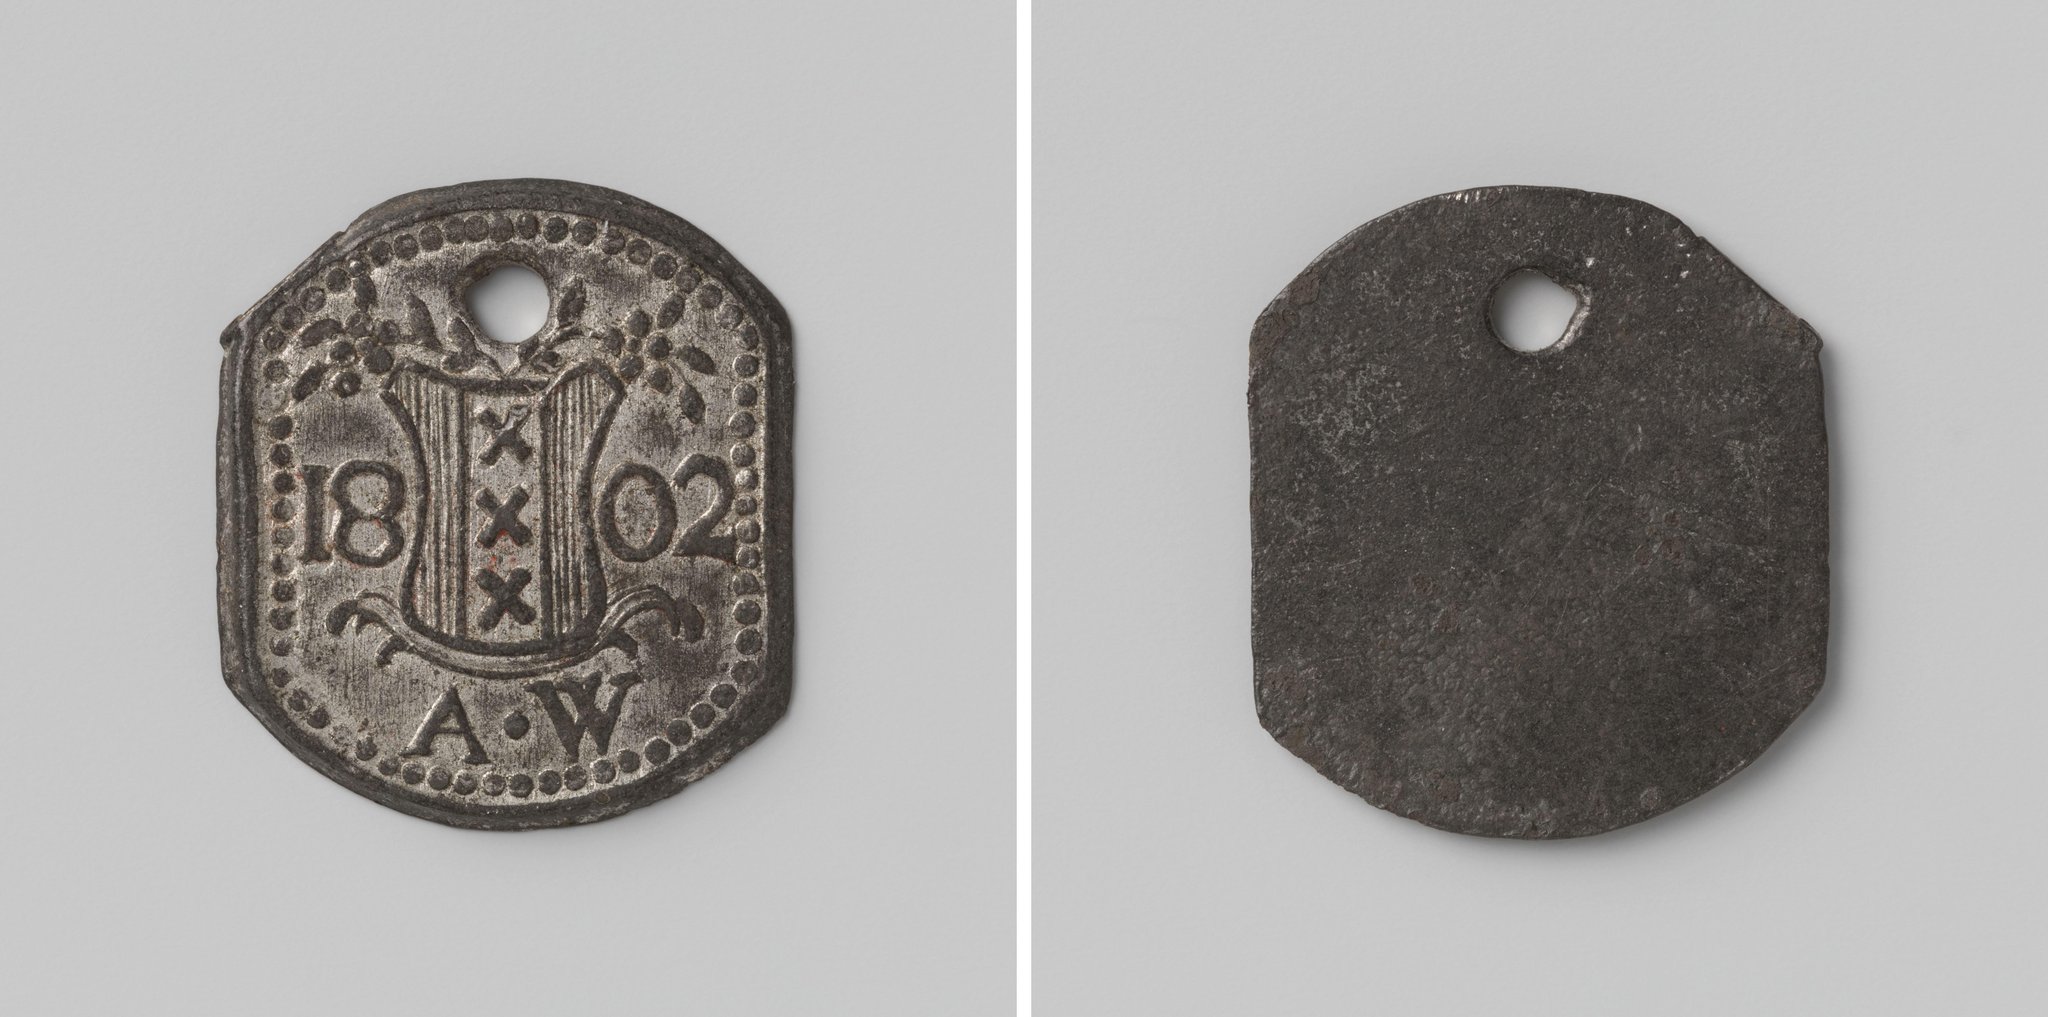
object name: hondenbelastingloodje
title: Aalmoezeniersweeshuis te Amsterdam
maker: Anonymous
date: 1802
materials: tin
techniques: striking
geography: amsterdam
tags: amsterdam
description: eenzijdig, rechthoekig loodje met bolle boven- en onderzijden en met gat erin. Voorzijde: wapenschild op twee gekruiste bladertakken tussen jaartal boven opschrift AW. Keerzijde: blanco